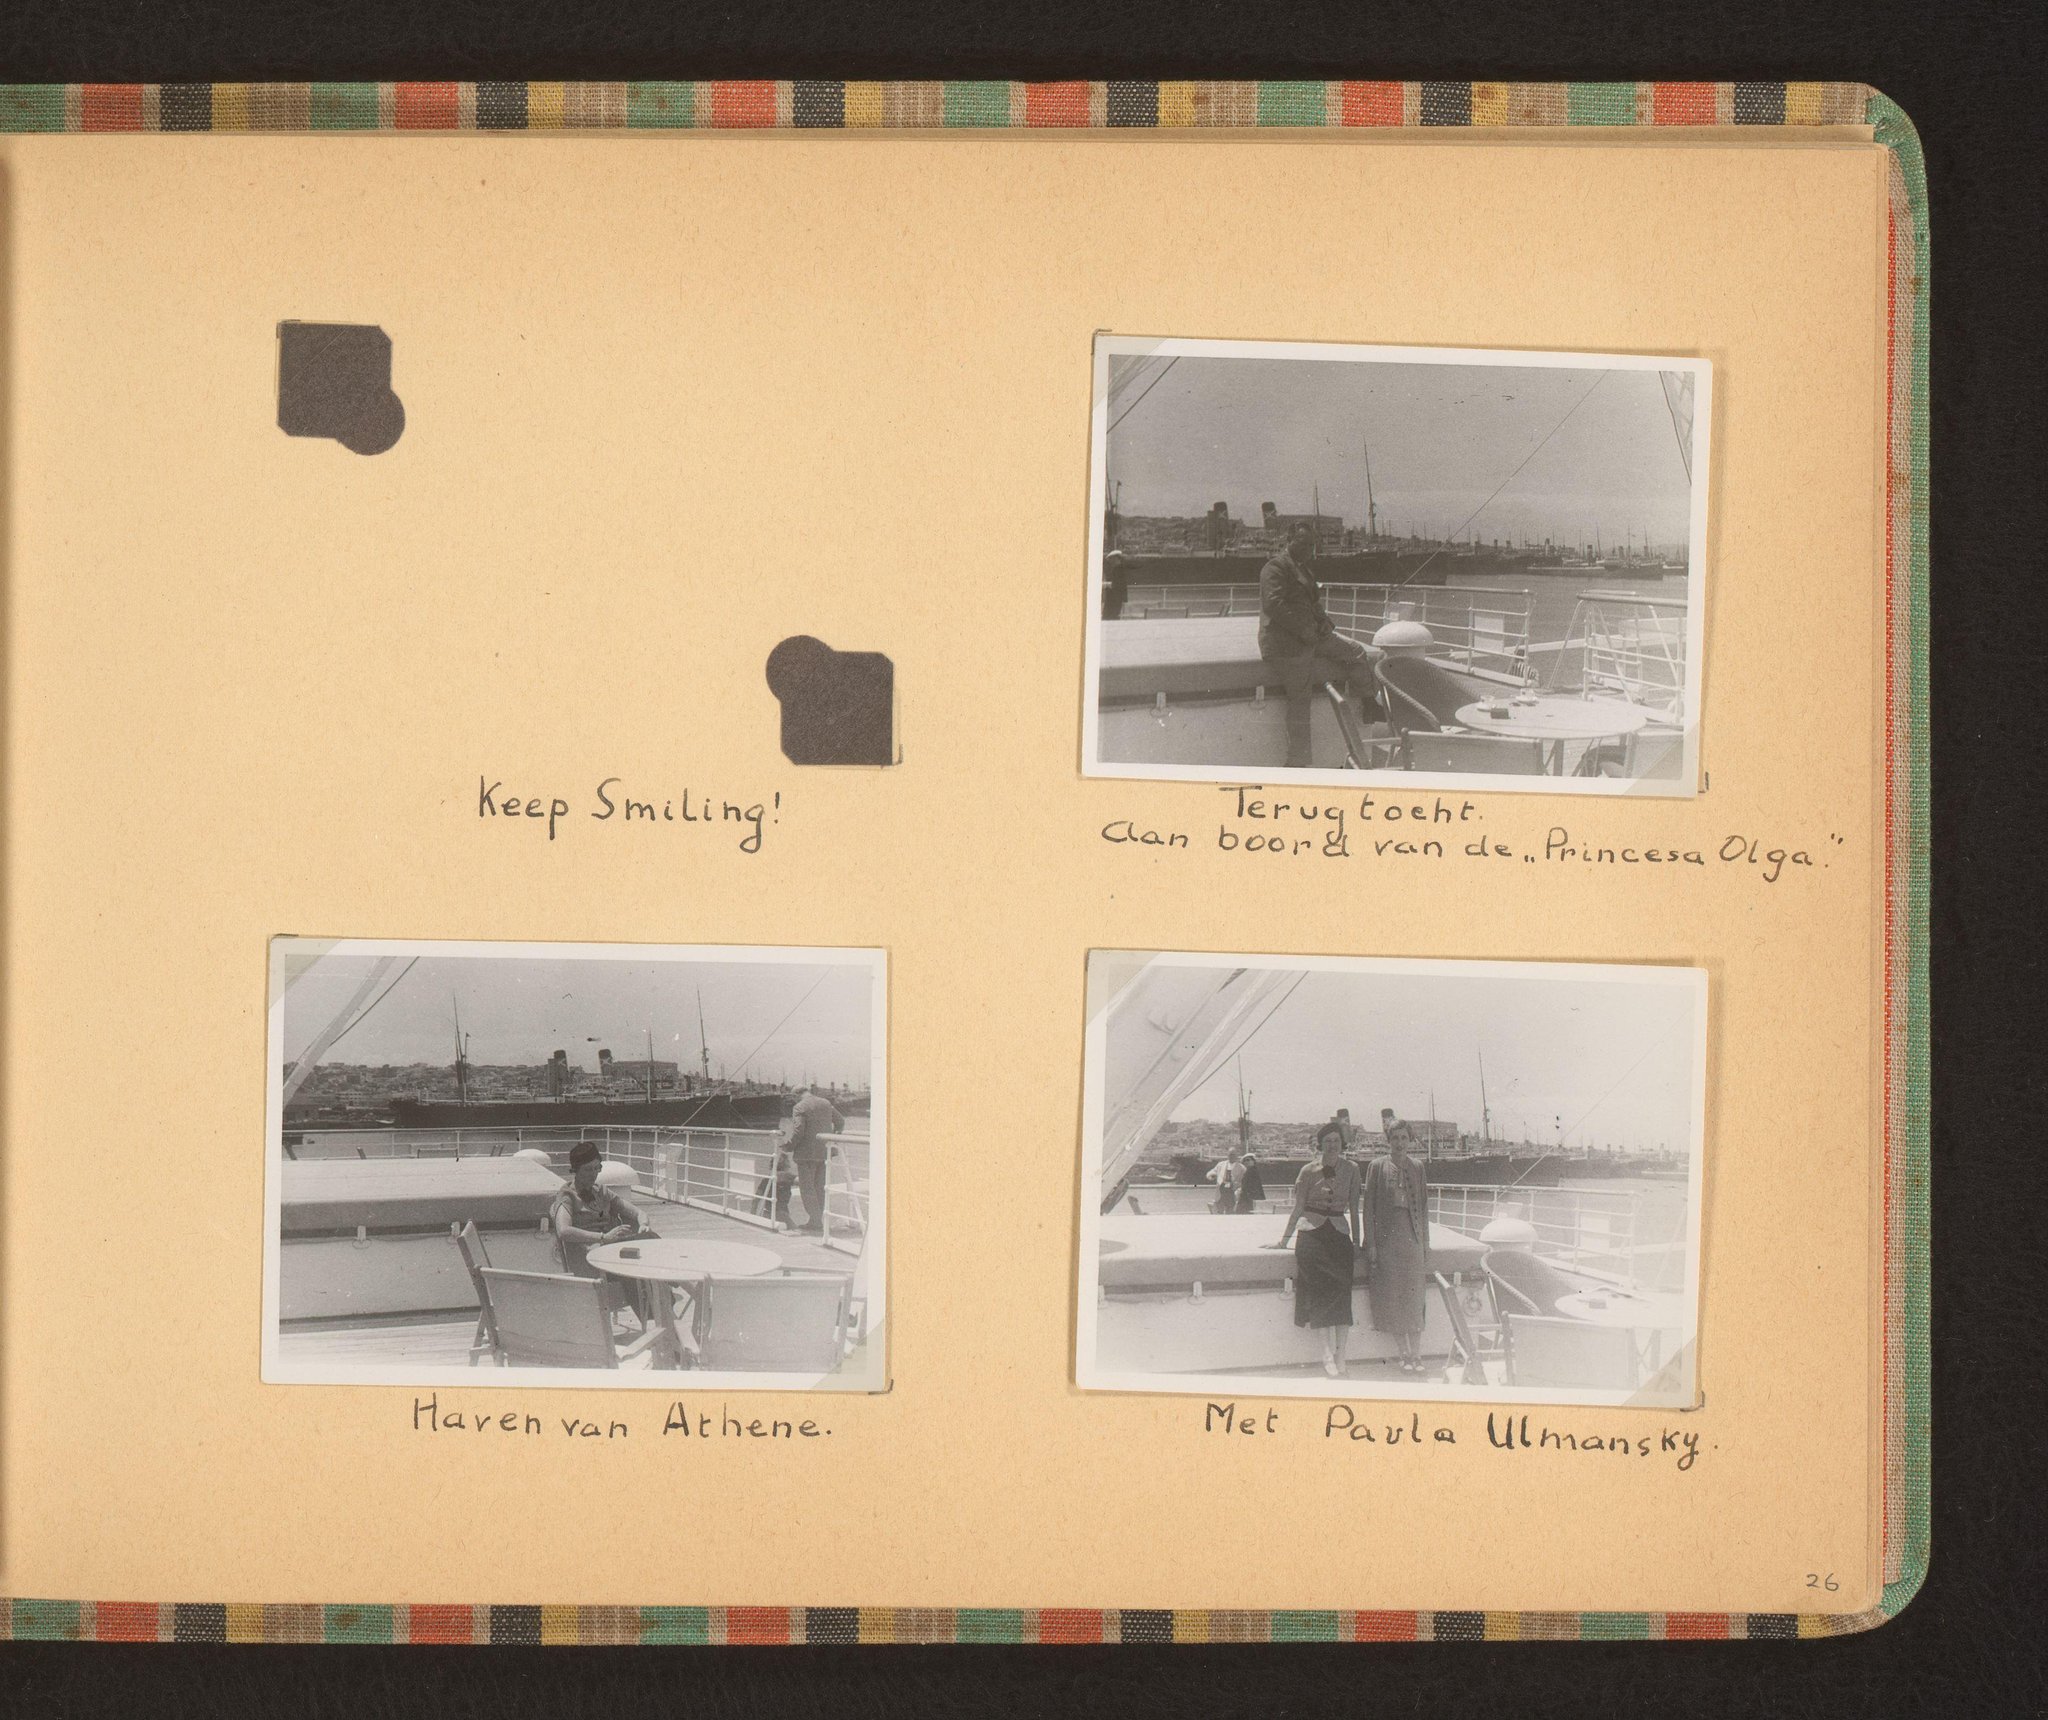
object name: photograph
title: Terugreis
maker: Anonymous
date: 1936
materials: paper, photographic support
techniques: gelatin silver print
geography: athens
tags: tourism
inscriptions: inscription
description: Albumblad met drie foto's aan boord van de 'Princesa Olga' in de haven van Athene tijdens de terugreis. Onderdeel van een album over een vakantiereis over de Nijl in 1936.